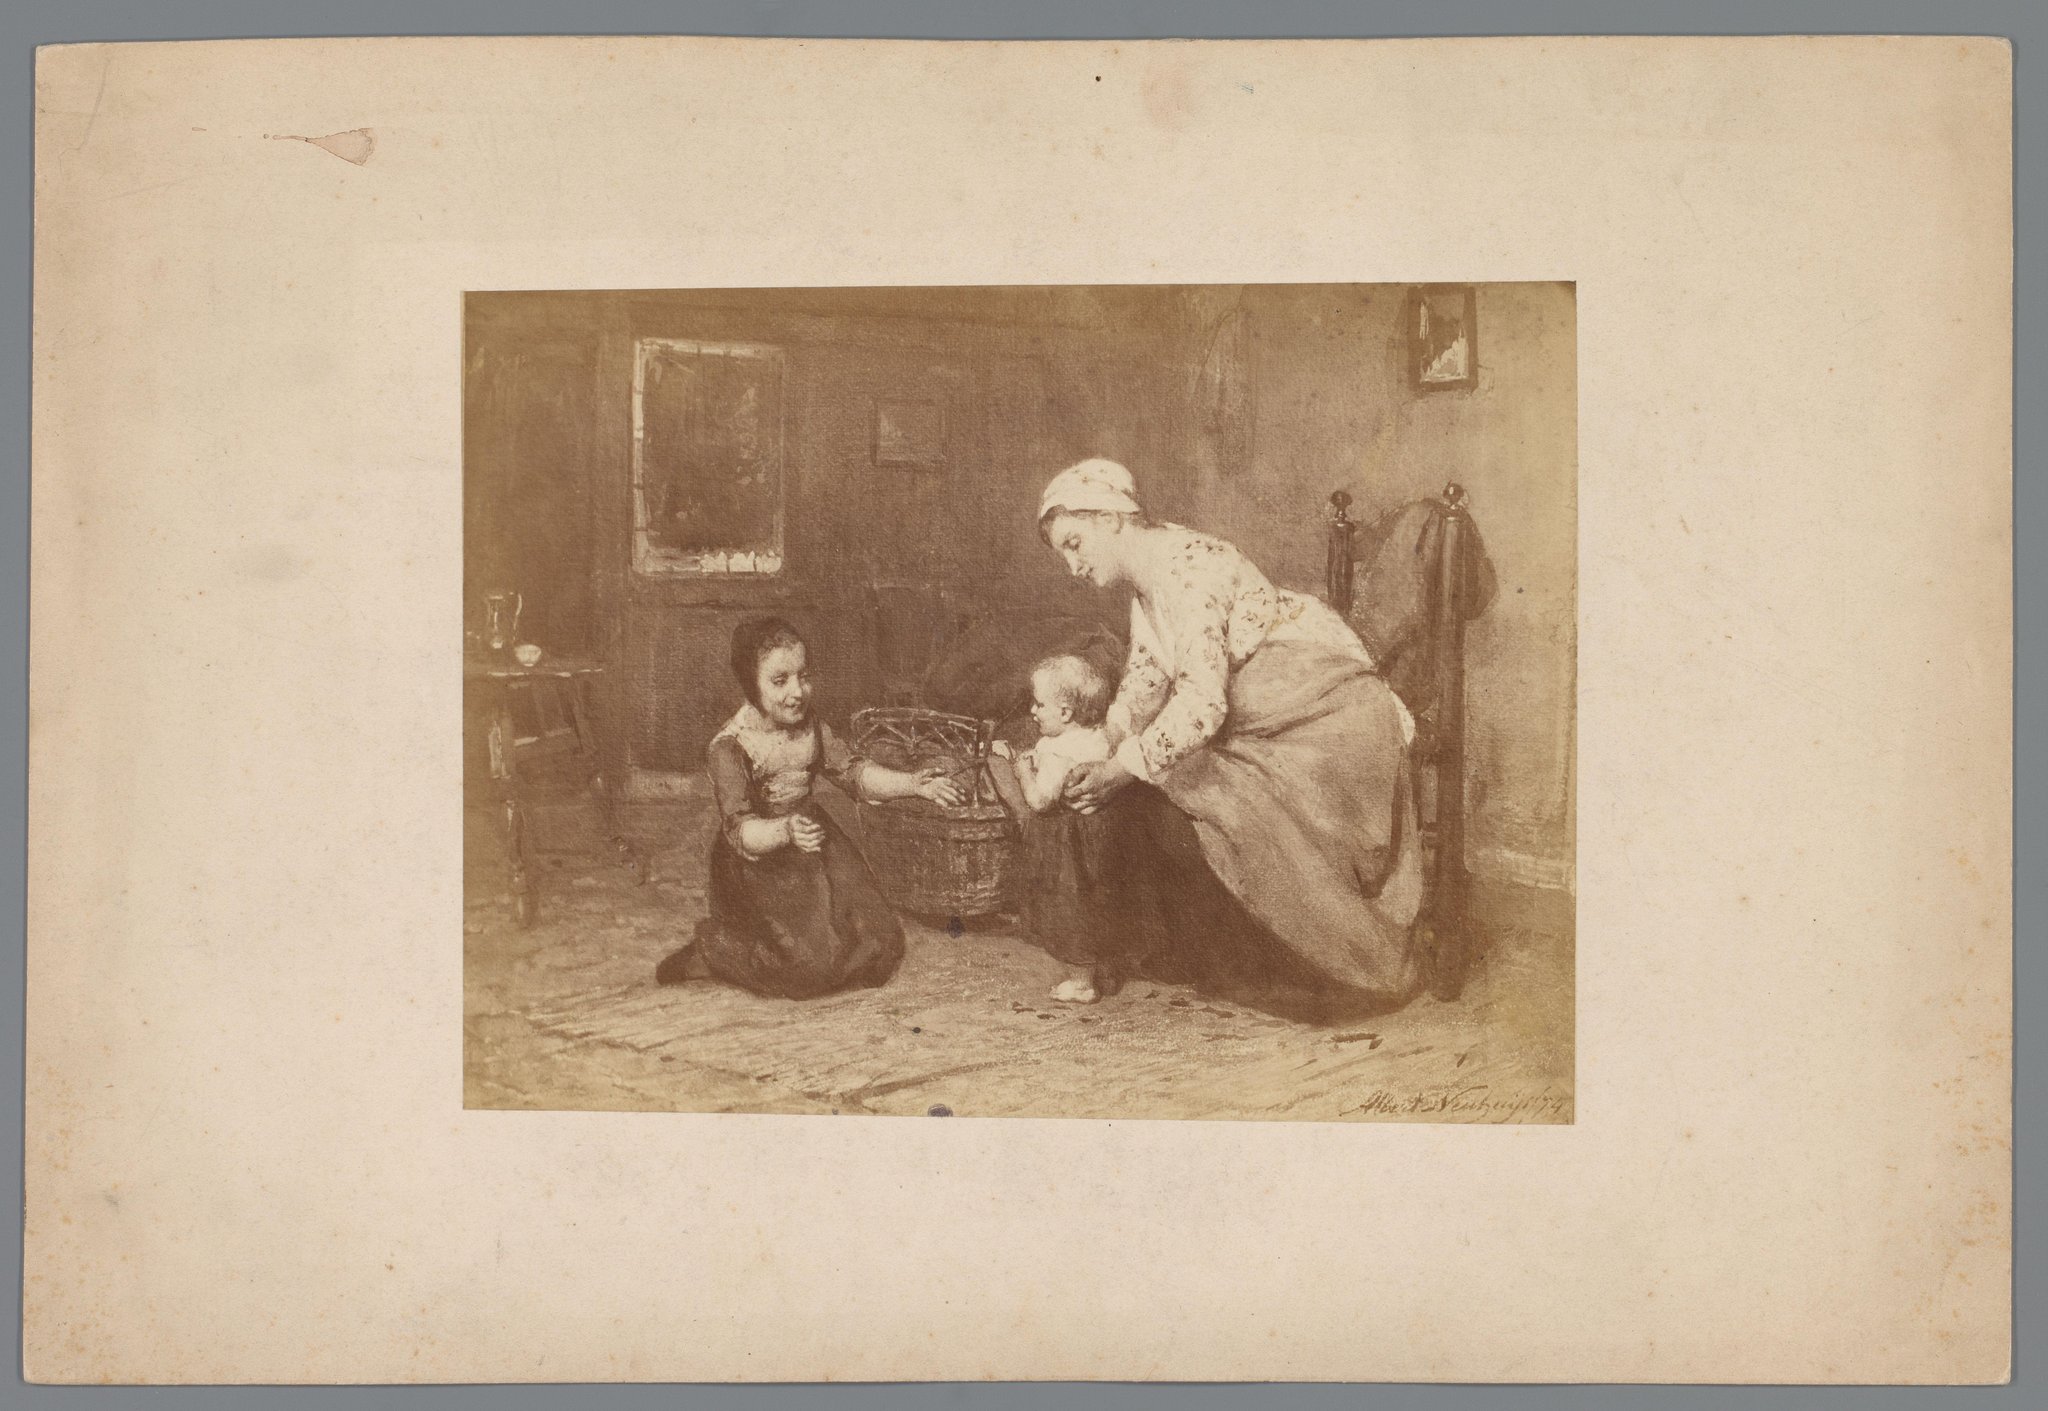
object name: photograph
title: Schilderij van Albert Neuhuys met daarop een vrouw met twee kleine kinderen in een huiskamer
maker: Anonymous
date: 1880-1914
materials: paper, photographic support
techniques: matte daylight collodion silver print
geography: netherlands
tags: utrecht, painter, print maker, draughtsman, albert neuhuys (1844-1914)